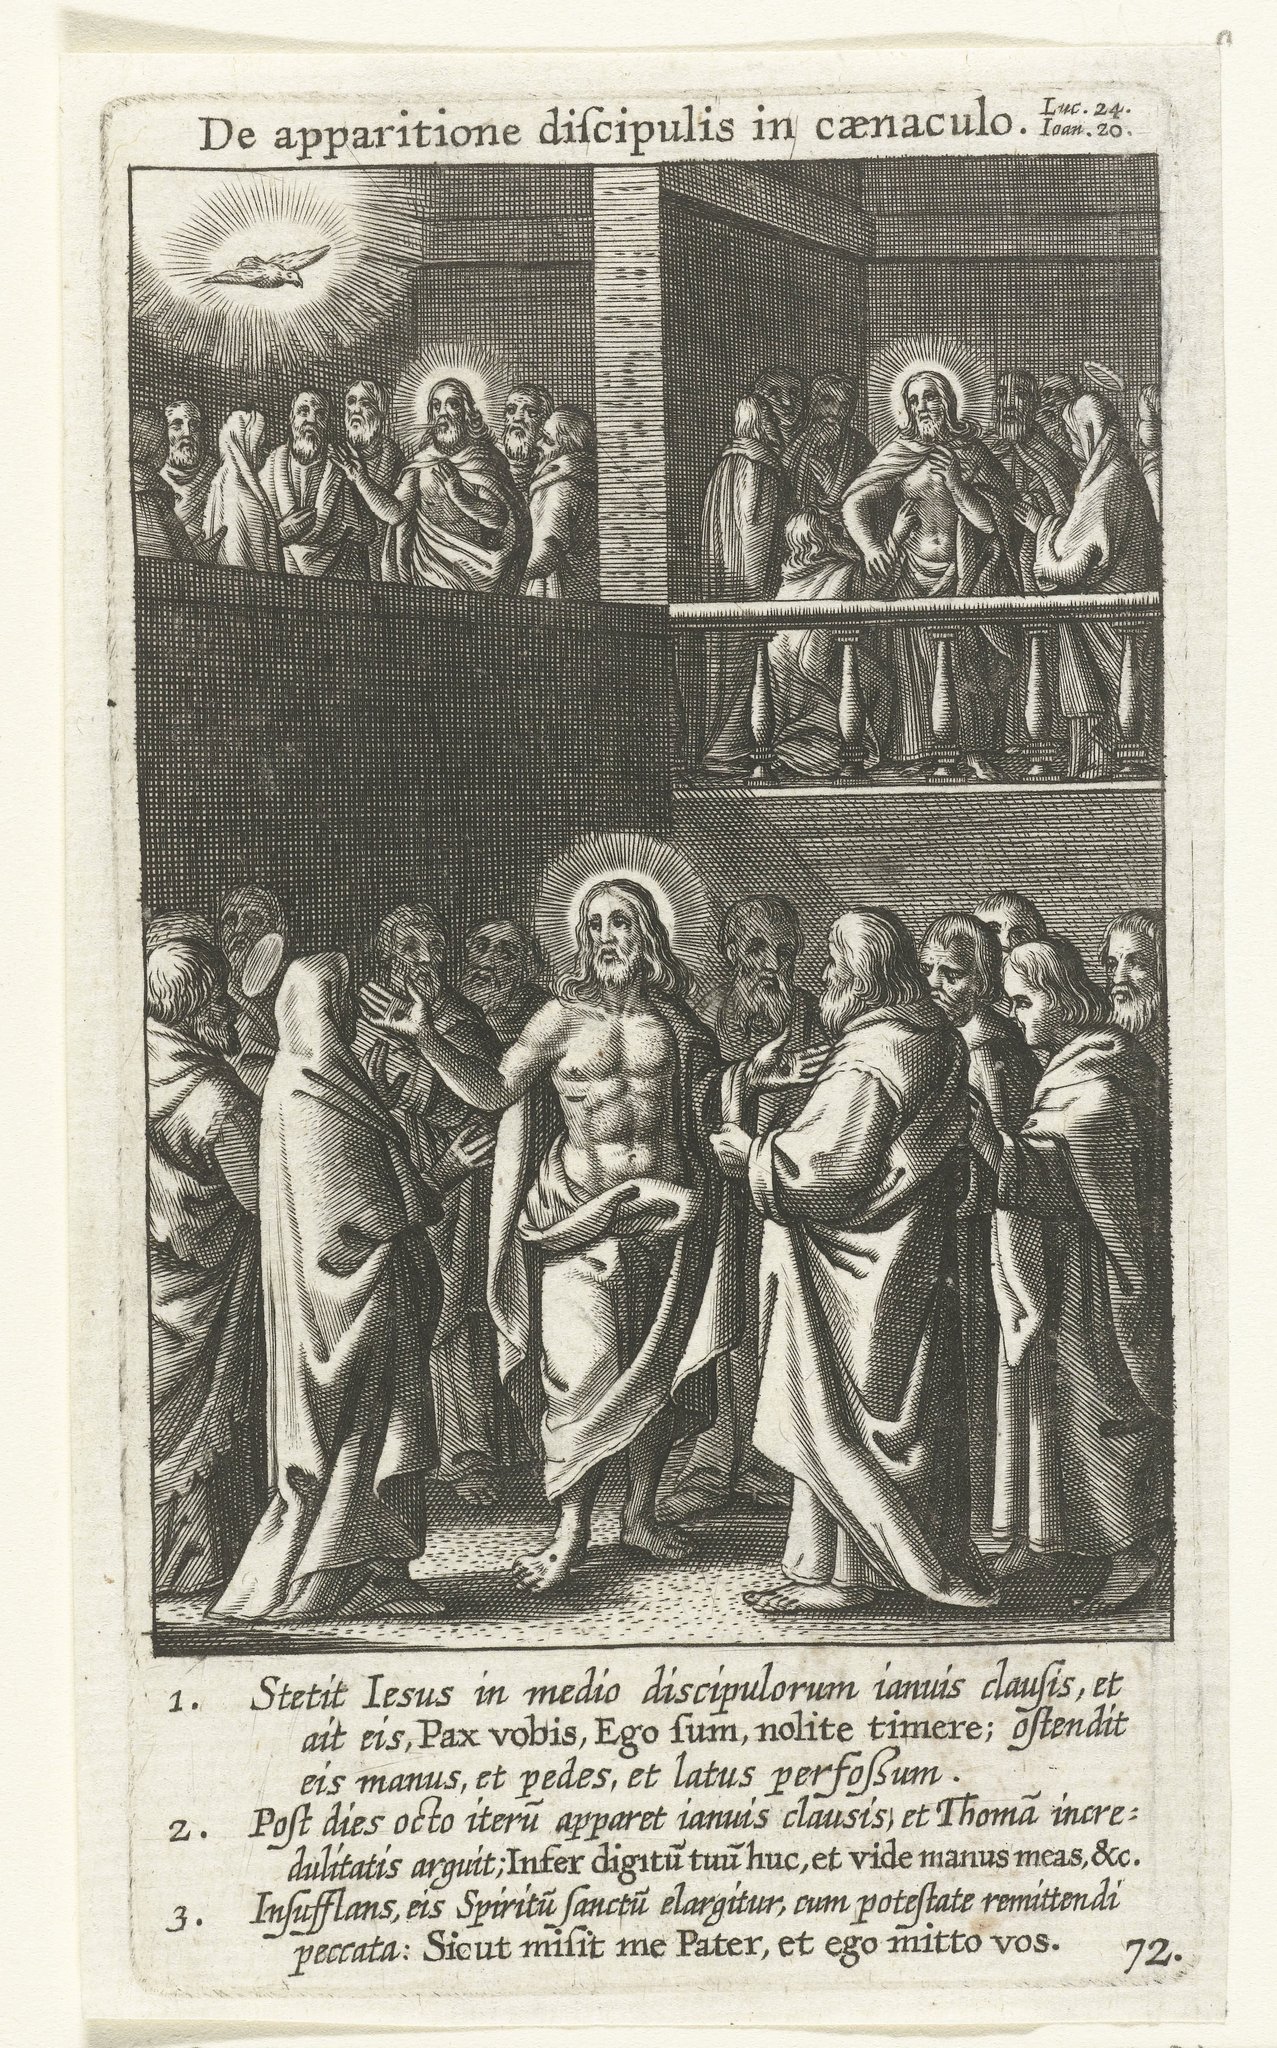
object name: book illustration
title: Christus verschijnt aan de discipelen en de ongelovige Thomas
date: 1590-1622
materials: paper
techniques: engraving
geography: antwerp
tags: the incredulity of thomas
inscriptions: collector's mark: Lugt 240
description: Prent uit: Joannes Bourgois, Vitae passionis et mortis Jesu Christi Somini nostri mysteria, Antwerpen Hendrick Aertssens, 1622, afb. 72